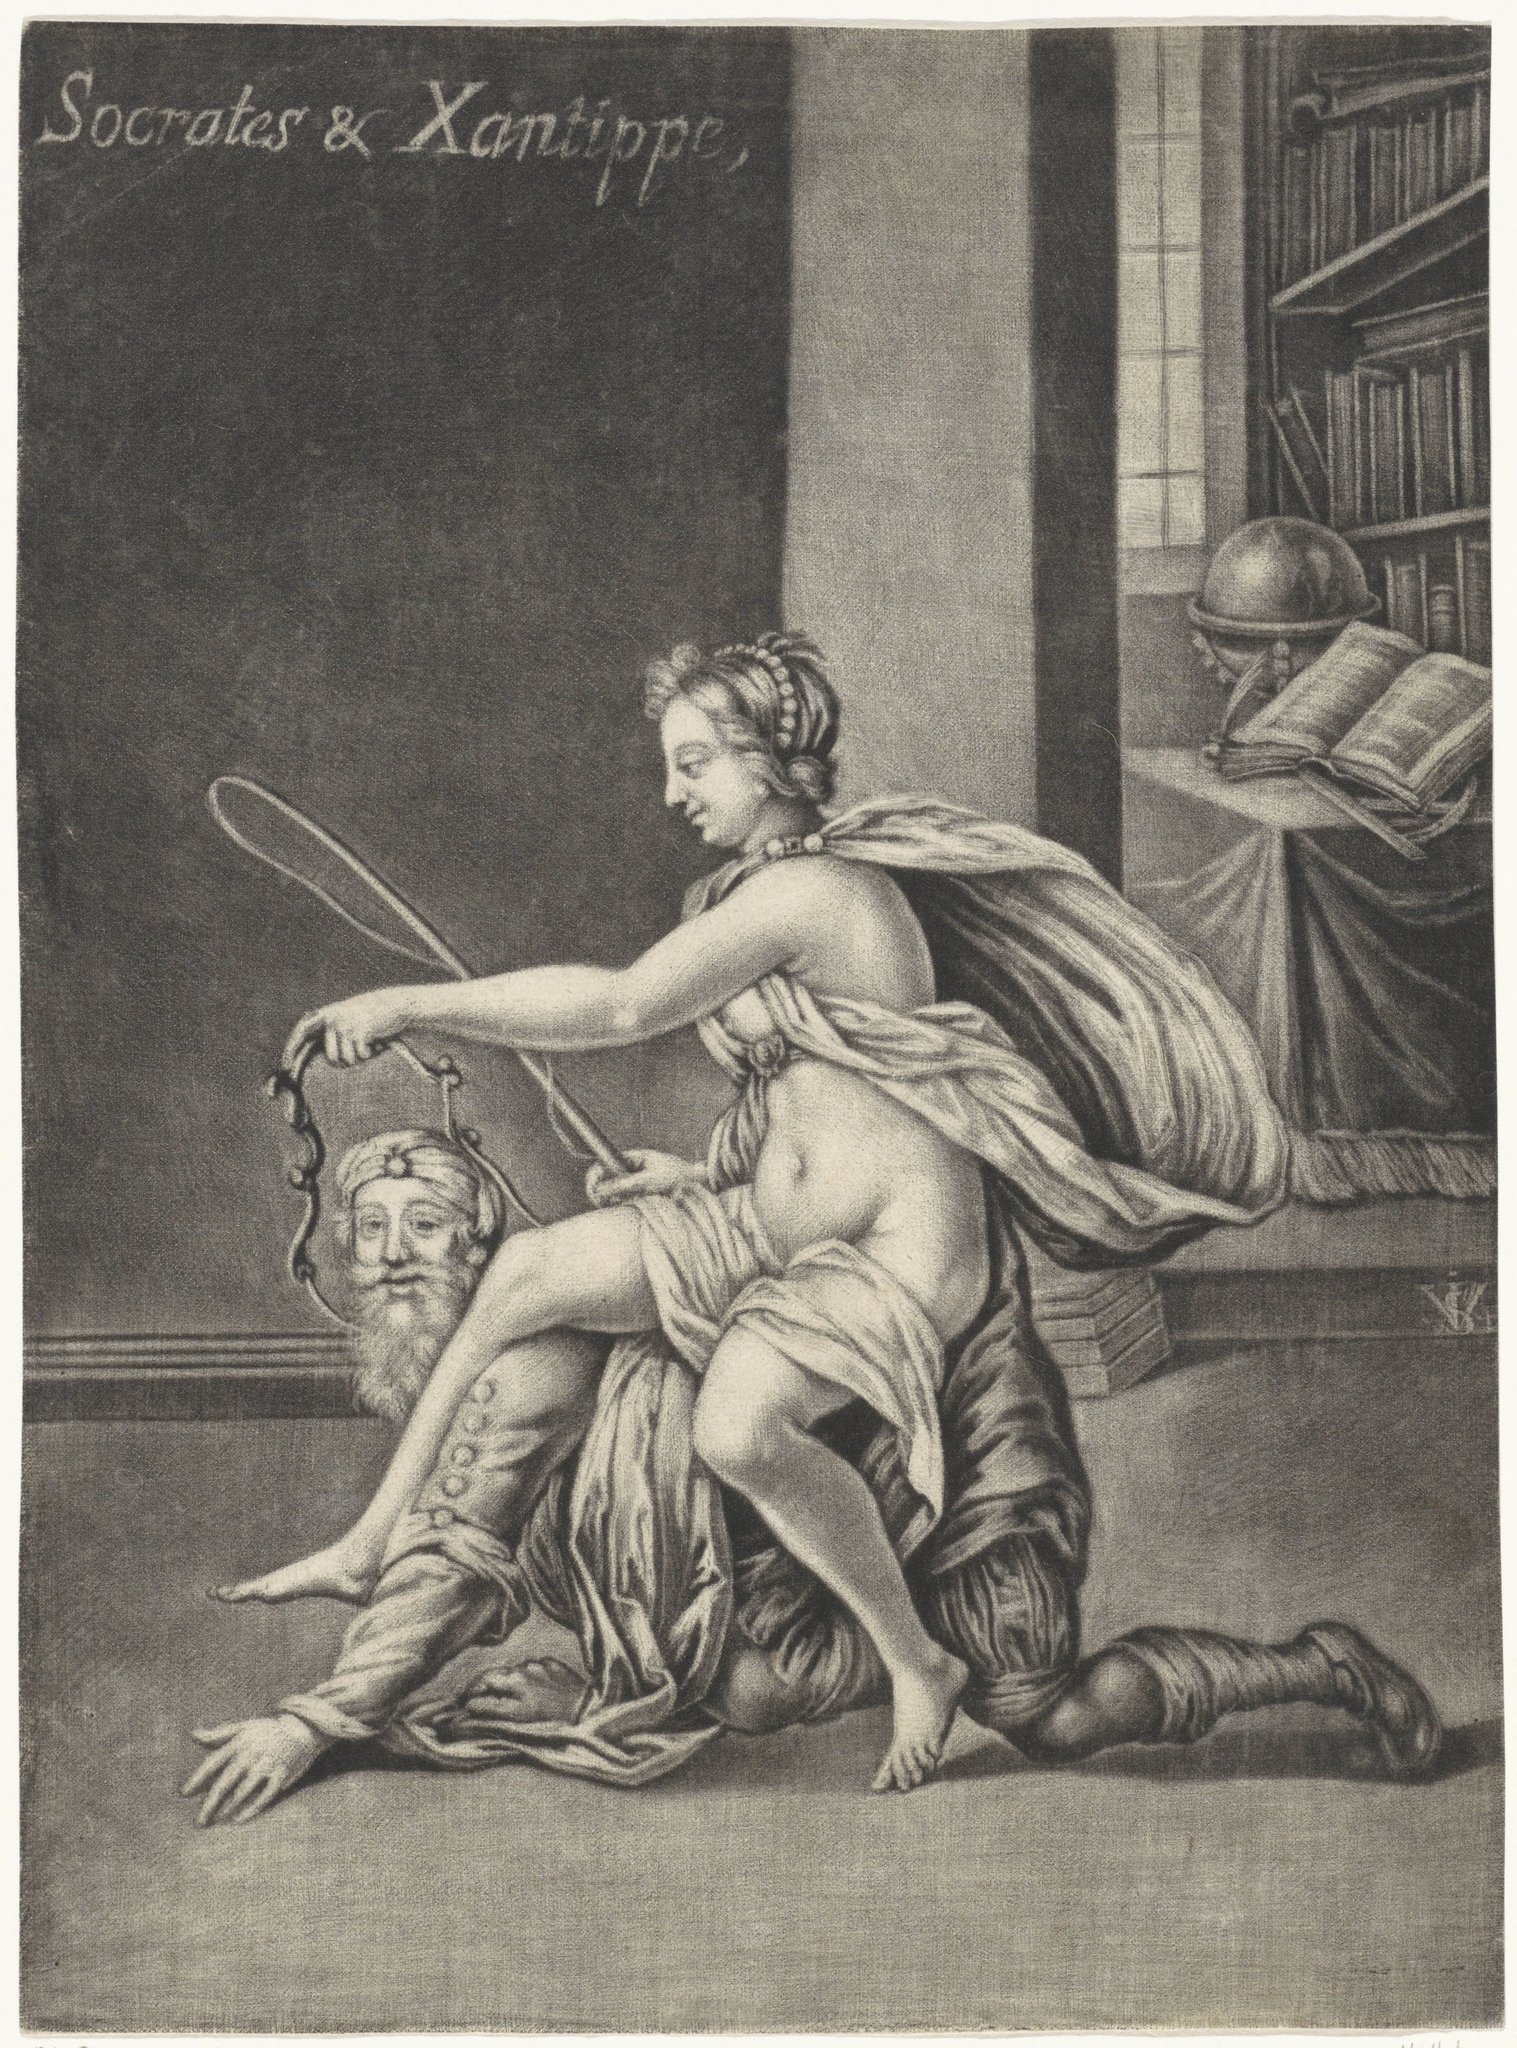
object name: print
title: Socrates & Xantippe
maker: jan van somer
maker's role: draughtsman, print maker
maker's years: 1645-1699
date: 1655-1700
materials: paper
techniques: mezzotint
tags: book, xanthippe pours water over socrates' head, dominating wife, globe, whip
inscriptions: collector's mark: Lugt 2228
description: De halfnaakte Xantippe zit op de rug van haar kruipende man Socrates. Ze heeft een zweep in de ene en een bit in de andere hand. Op de achtergrond een boekenkast en een tafel met een boek en een globe.